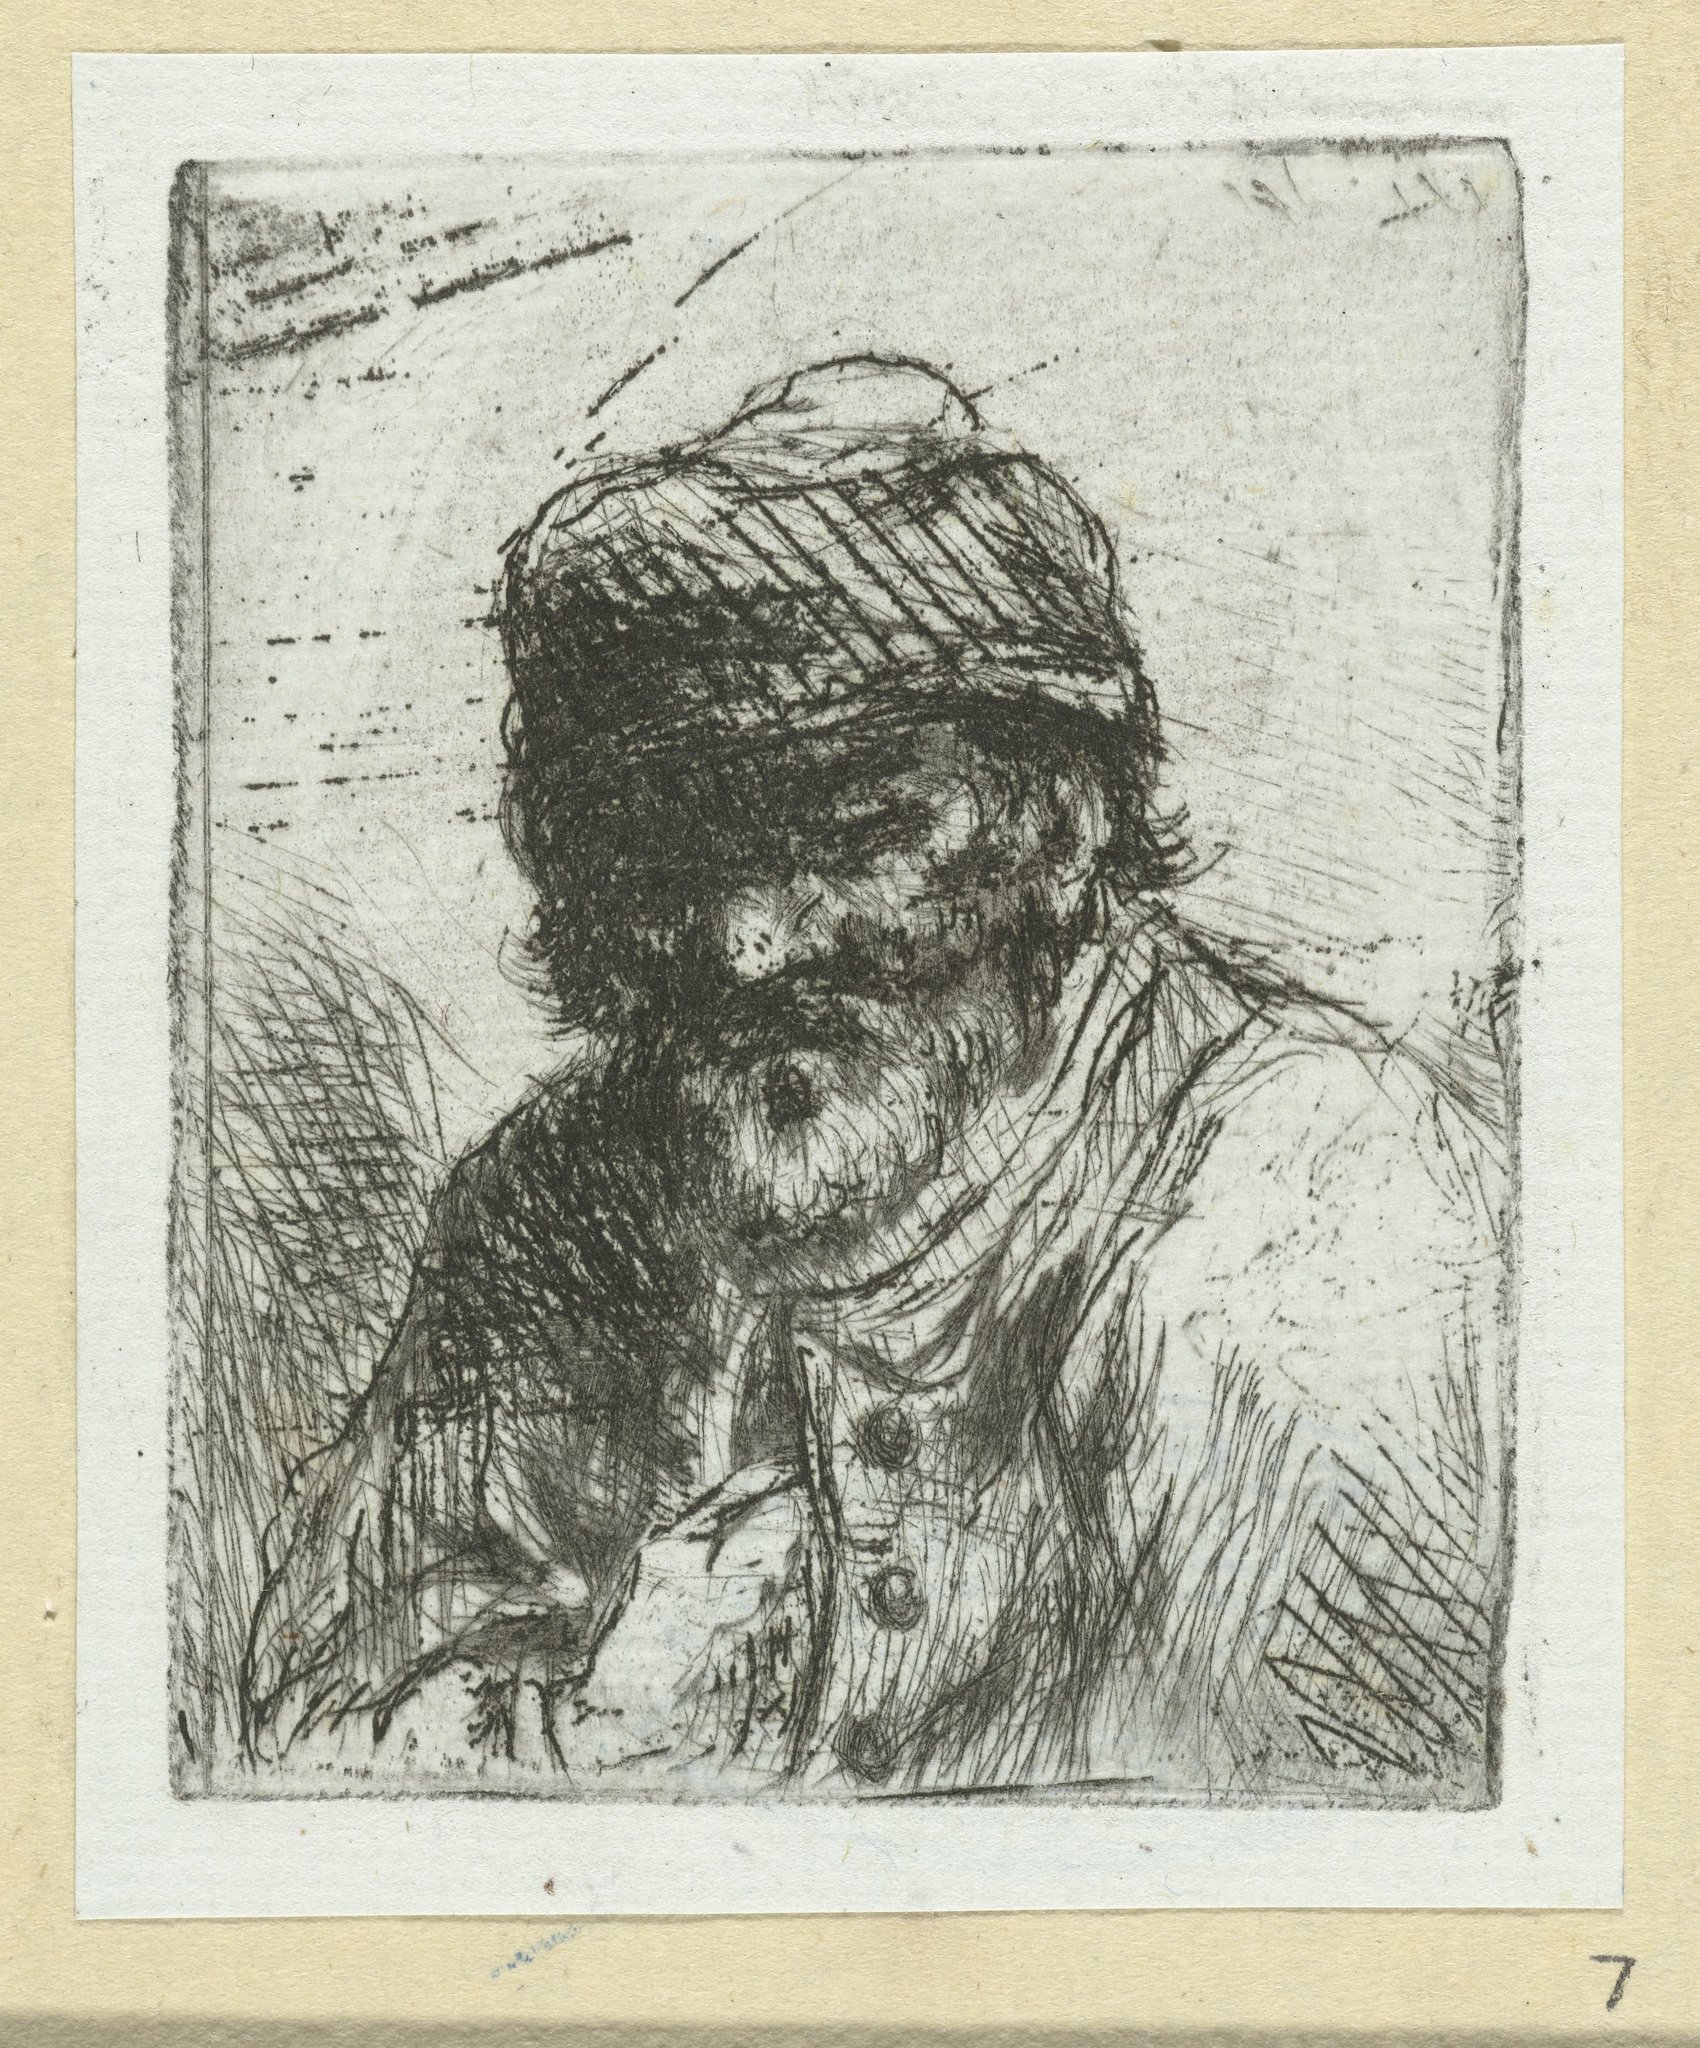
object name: print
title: Bebaarde oude man met muts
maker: jan chalon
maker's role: print maker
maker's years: 1738-1795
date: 1748-1795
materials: paper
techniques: drypoint, etching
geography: northern netherlands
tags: head-gear: cap (+ men's clothes), morphology of human expression (+ old male (human being))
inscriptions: collector's mark: Lugt 924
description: Oude man met baard. Hij draagt een muts en heeft zijn hand in zijn jas gestoken. Buste naar links.